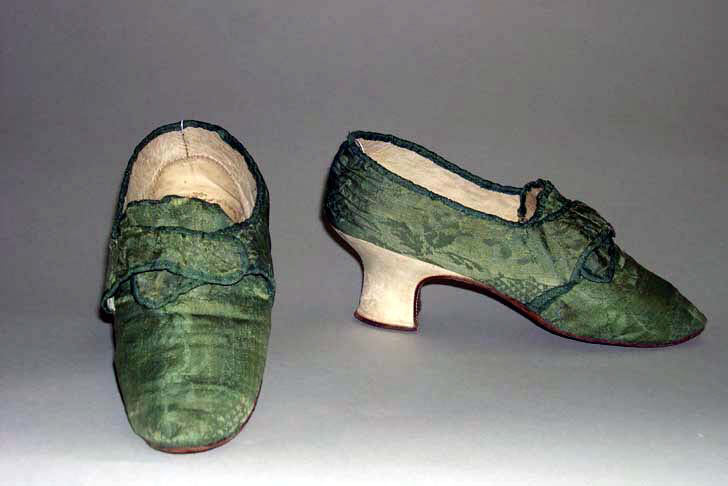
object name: slipper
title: Slippers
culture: british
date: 1770-1789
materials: silk